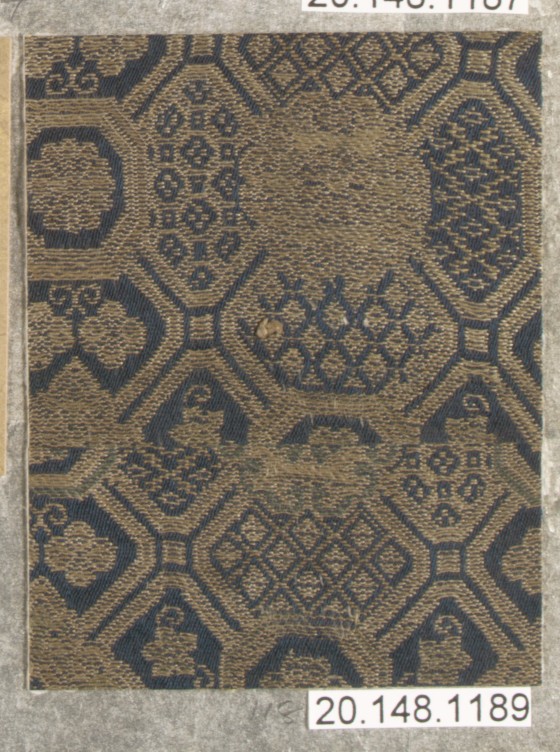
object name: piece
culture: japanese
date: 1701-1800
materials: silk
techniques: compound weave